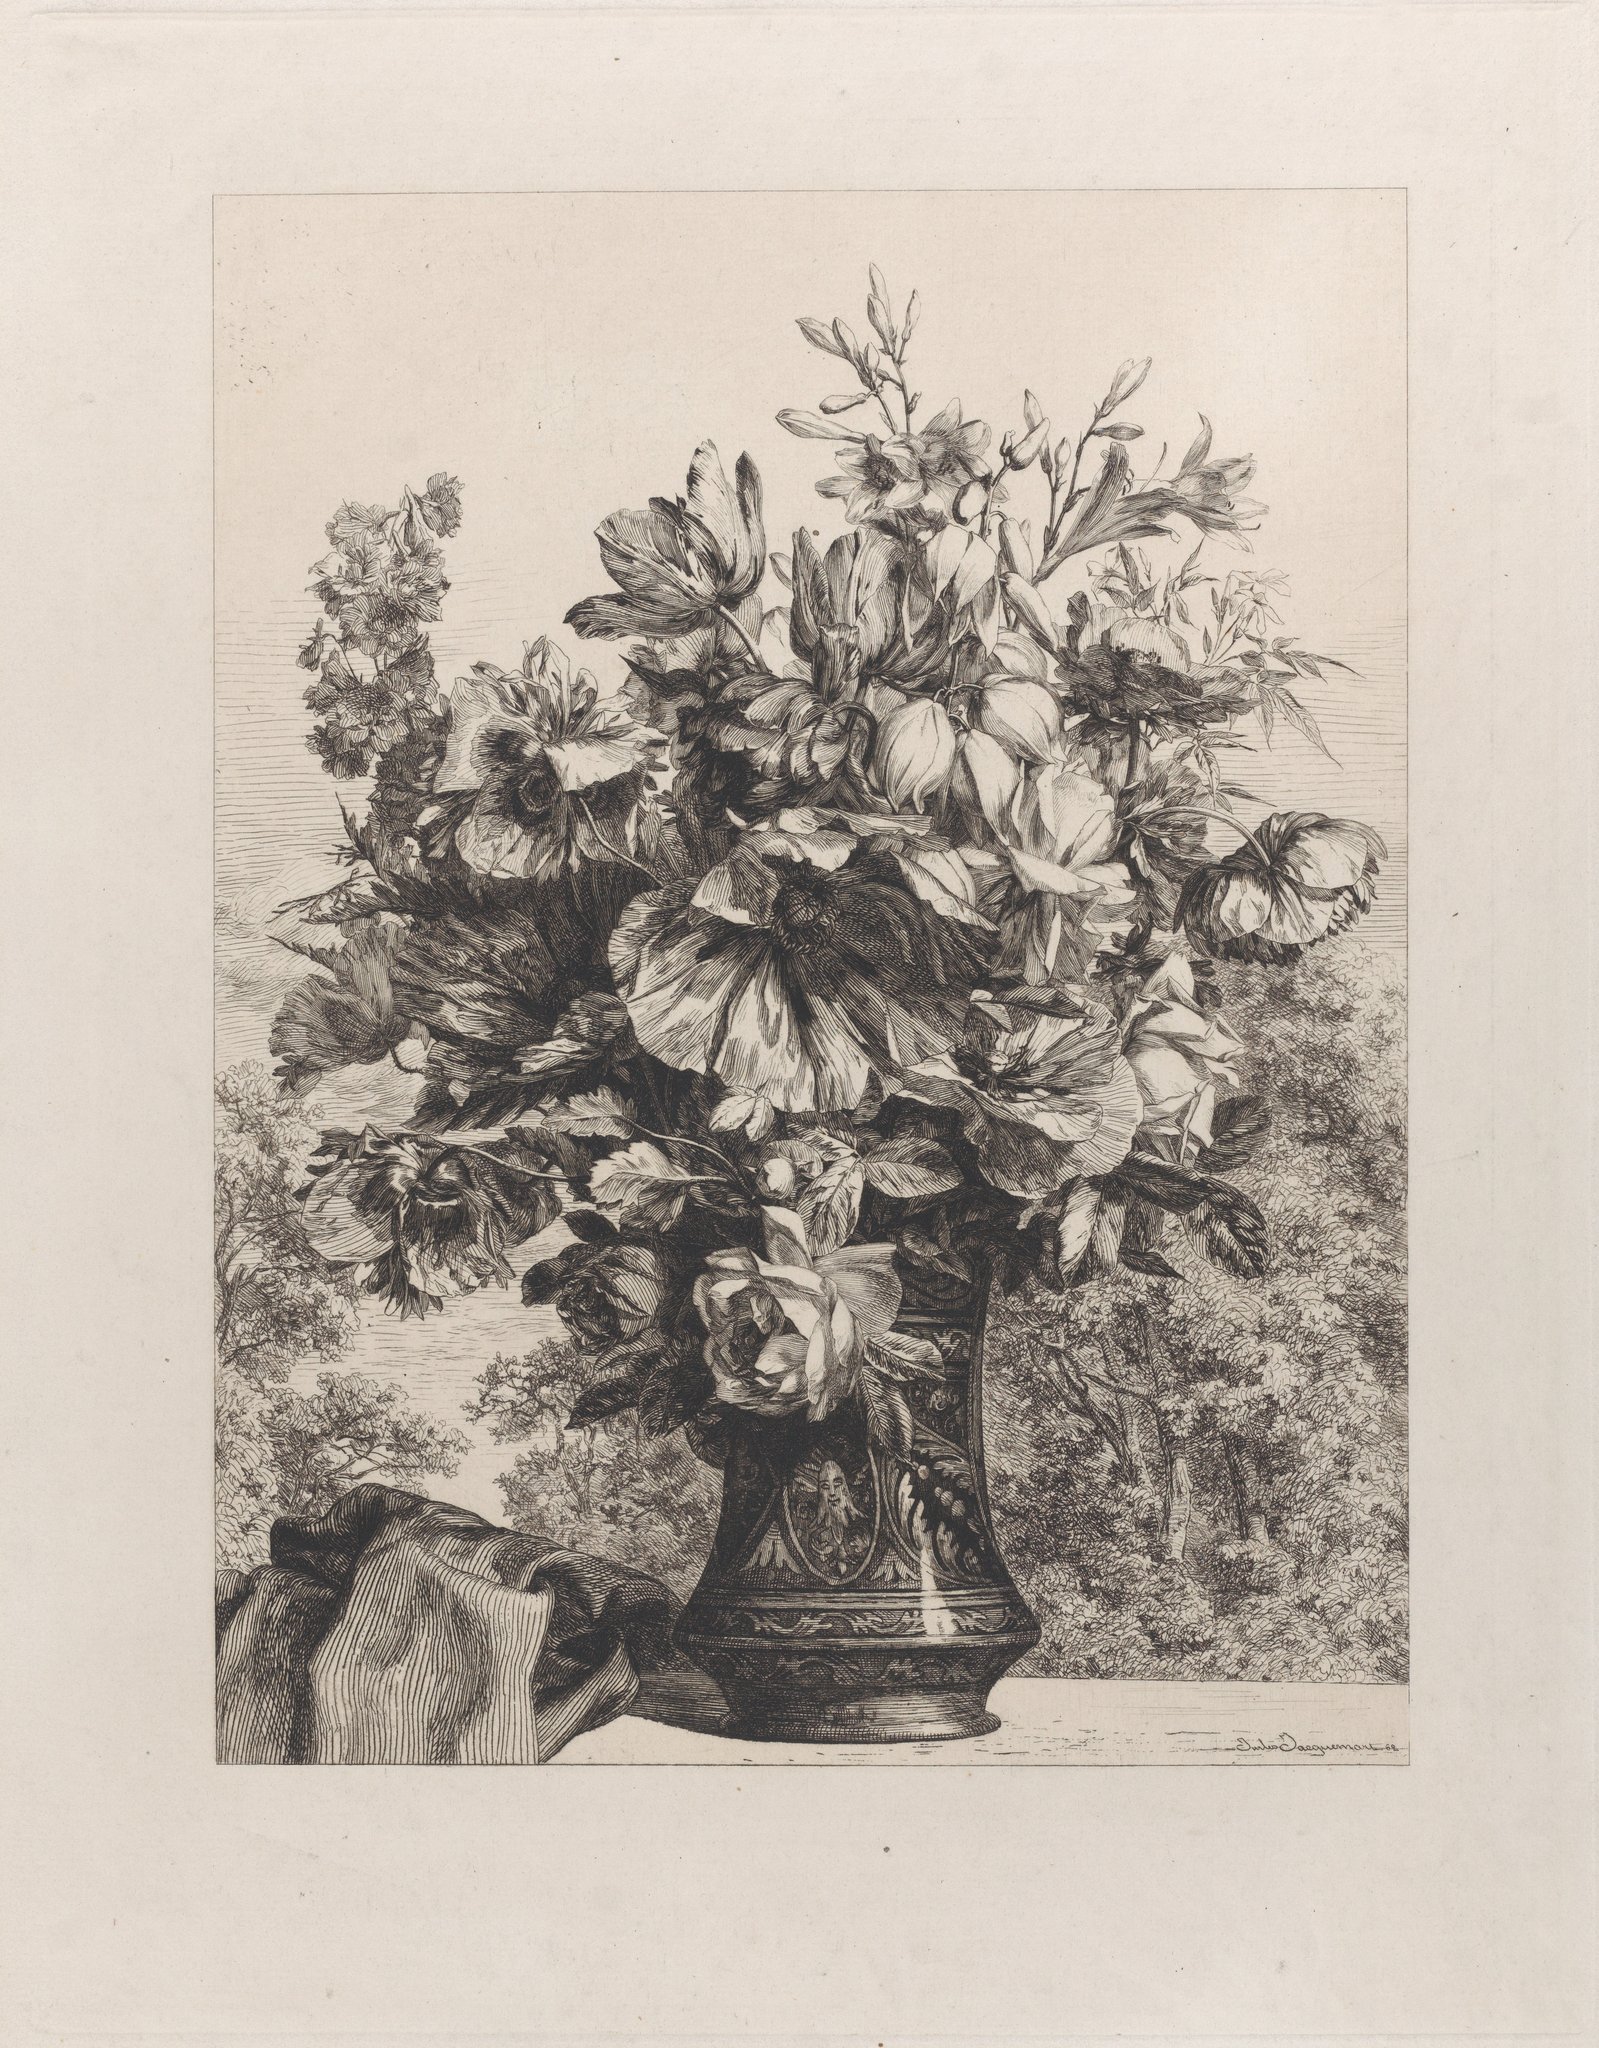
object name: print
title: Vase of Flowers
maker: jules-ferdinand jacquemart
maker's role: artist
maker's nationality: french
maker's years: 1837-1880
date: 1862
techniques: etching